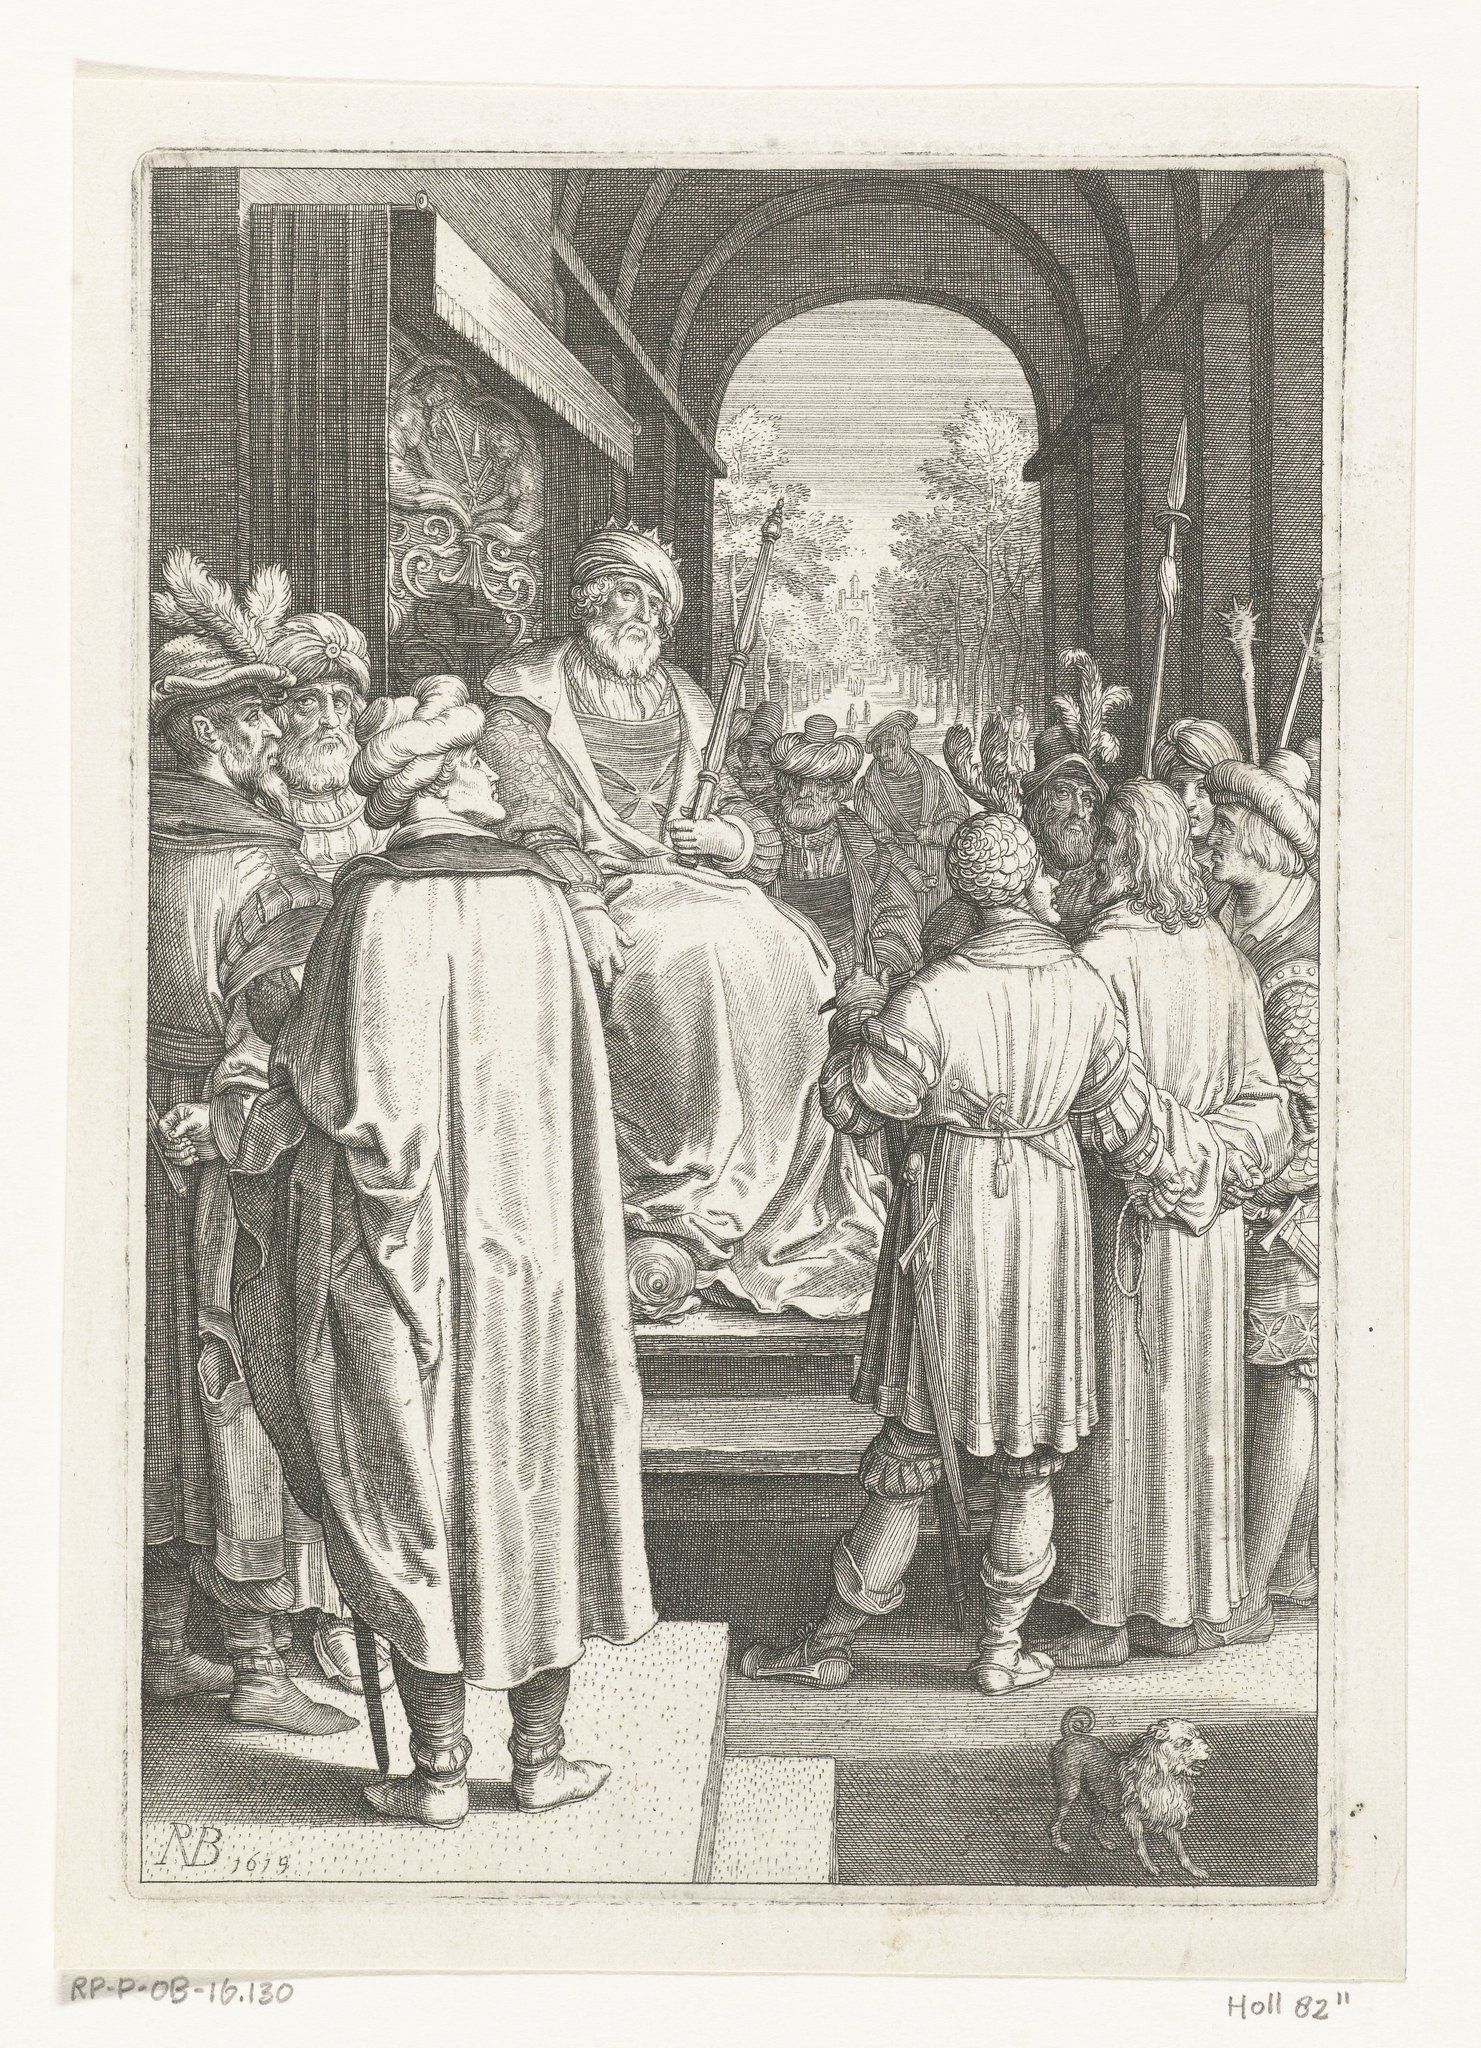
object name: print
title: De Passie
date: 1619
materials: paper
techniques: engraving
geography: netherlands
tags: christ before pontius pilate (matthew 27:11-26; mark 15:2-15; luke 23:2-7, 23:13-25; john 18:28 - 19:16)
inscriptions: collector's mark: Lugt 2228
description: Prent uit serie van twaalf prenten met scènes uit de Passie. Reeks geïnspireerd door de prenten van Hendrick Goltzius en Lucas van Leyden.